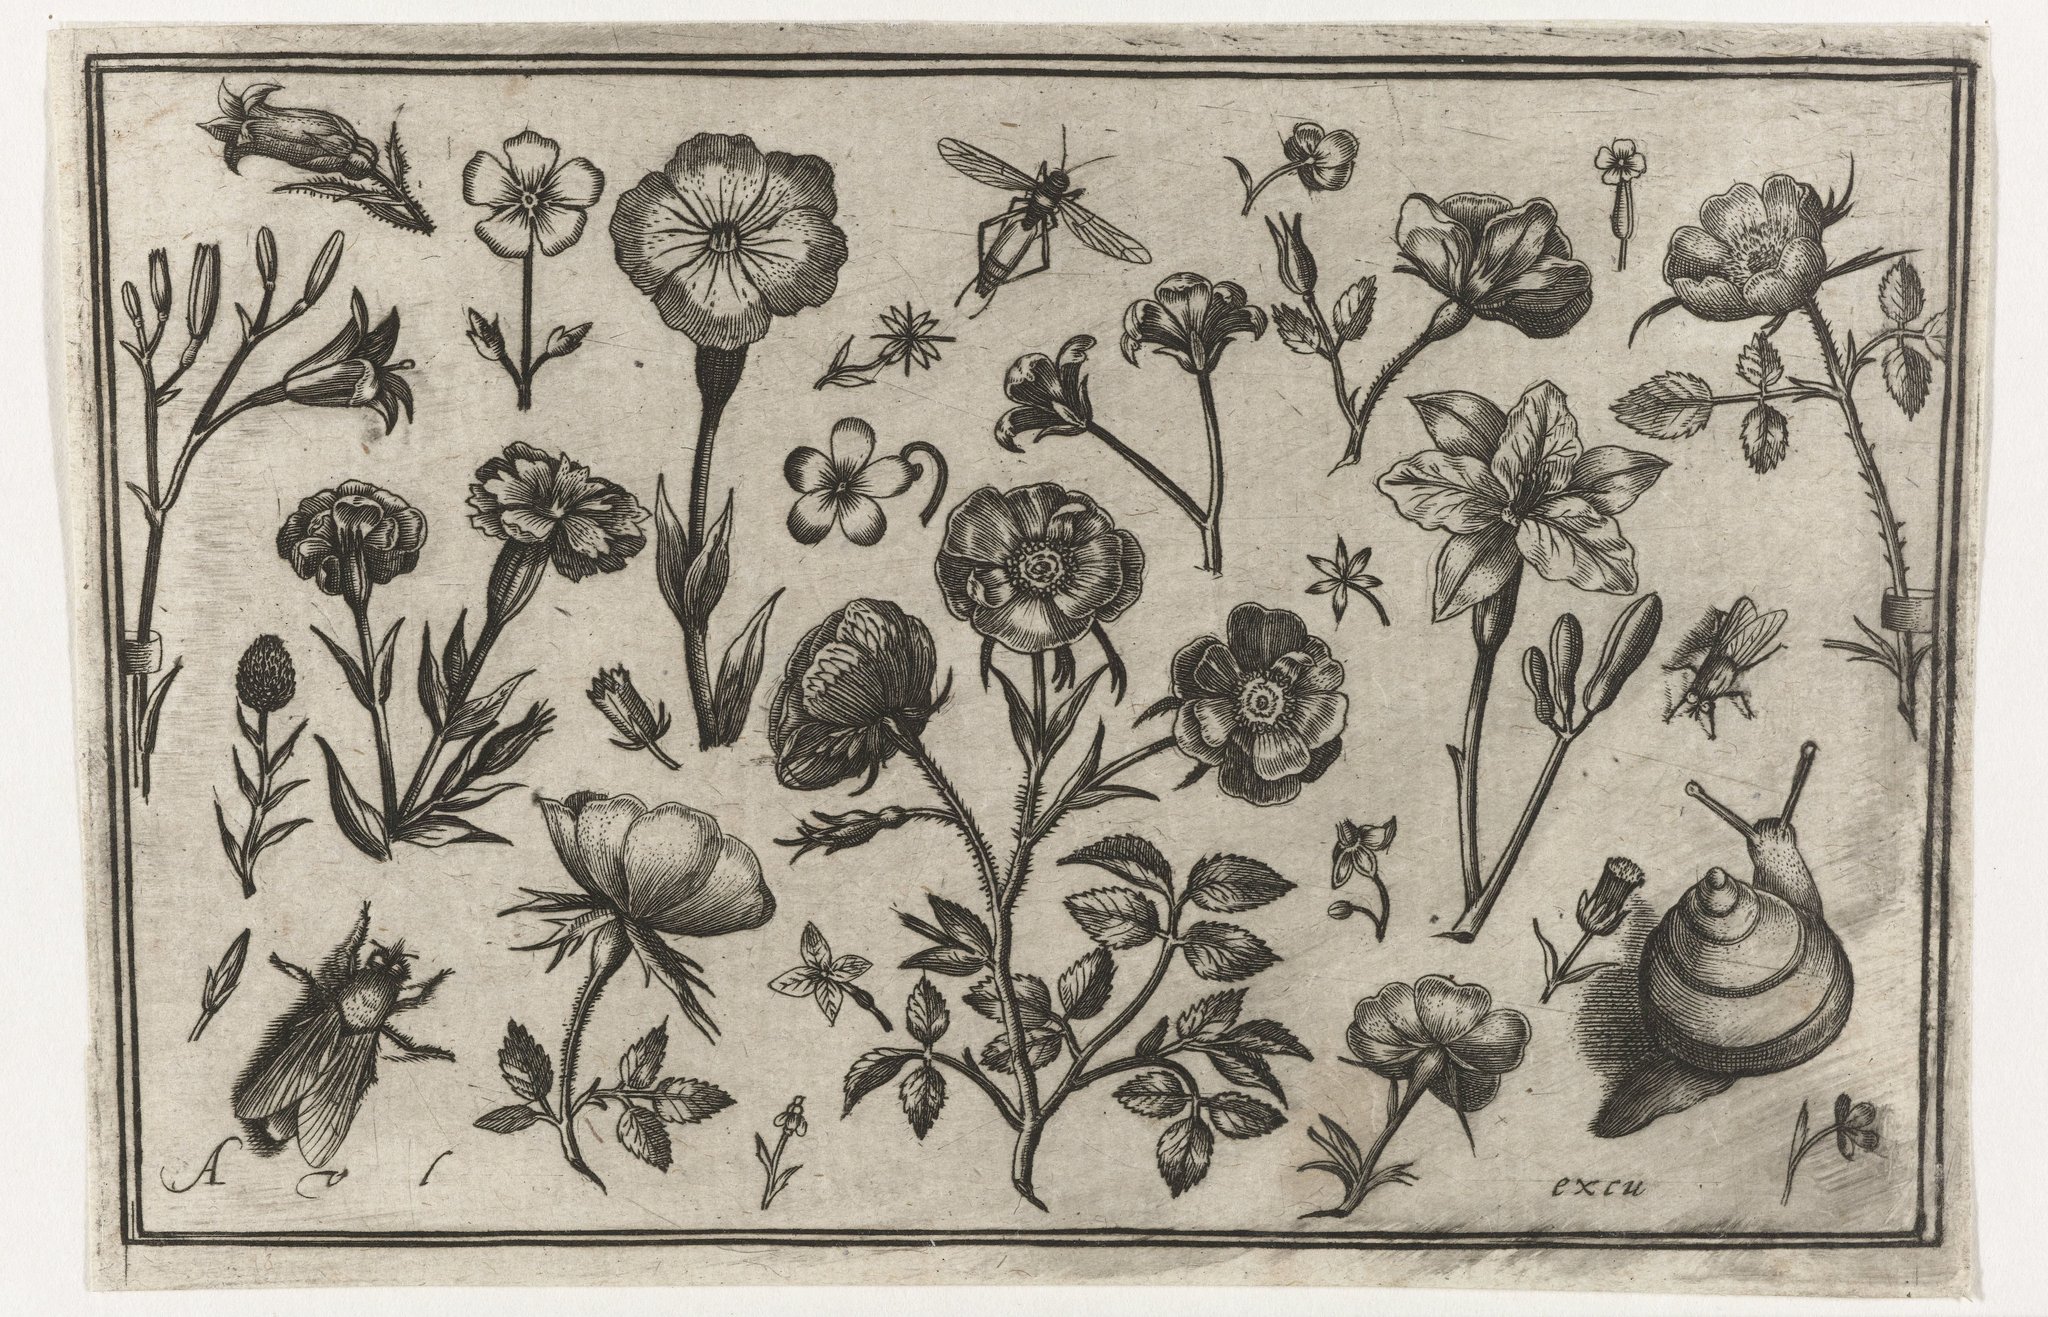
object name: print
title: Vogels, bloemen, insecten etc.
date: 1594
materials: paper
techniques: engraving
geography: netherlands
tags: flowers, molluscs: snail, insects: fly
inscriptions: collector's mark: Lugt 2228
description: Prent uit serie van onbekend aantal prenten met onder andere vogels, bloemen en insecten.